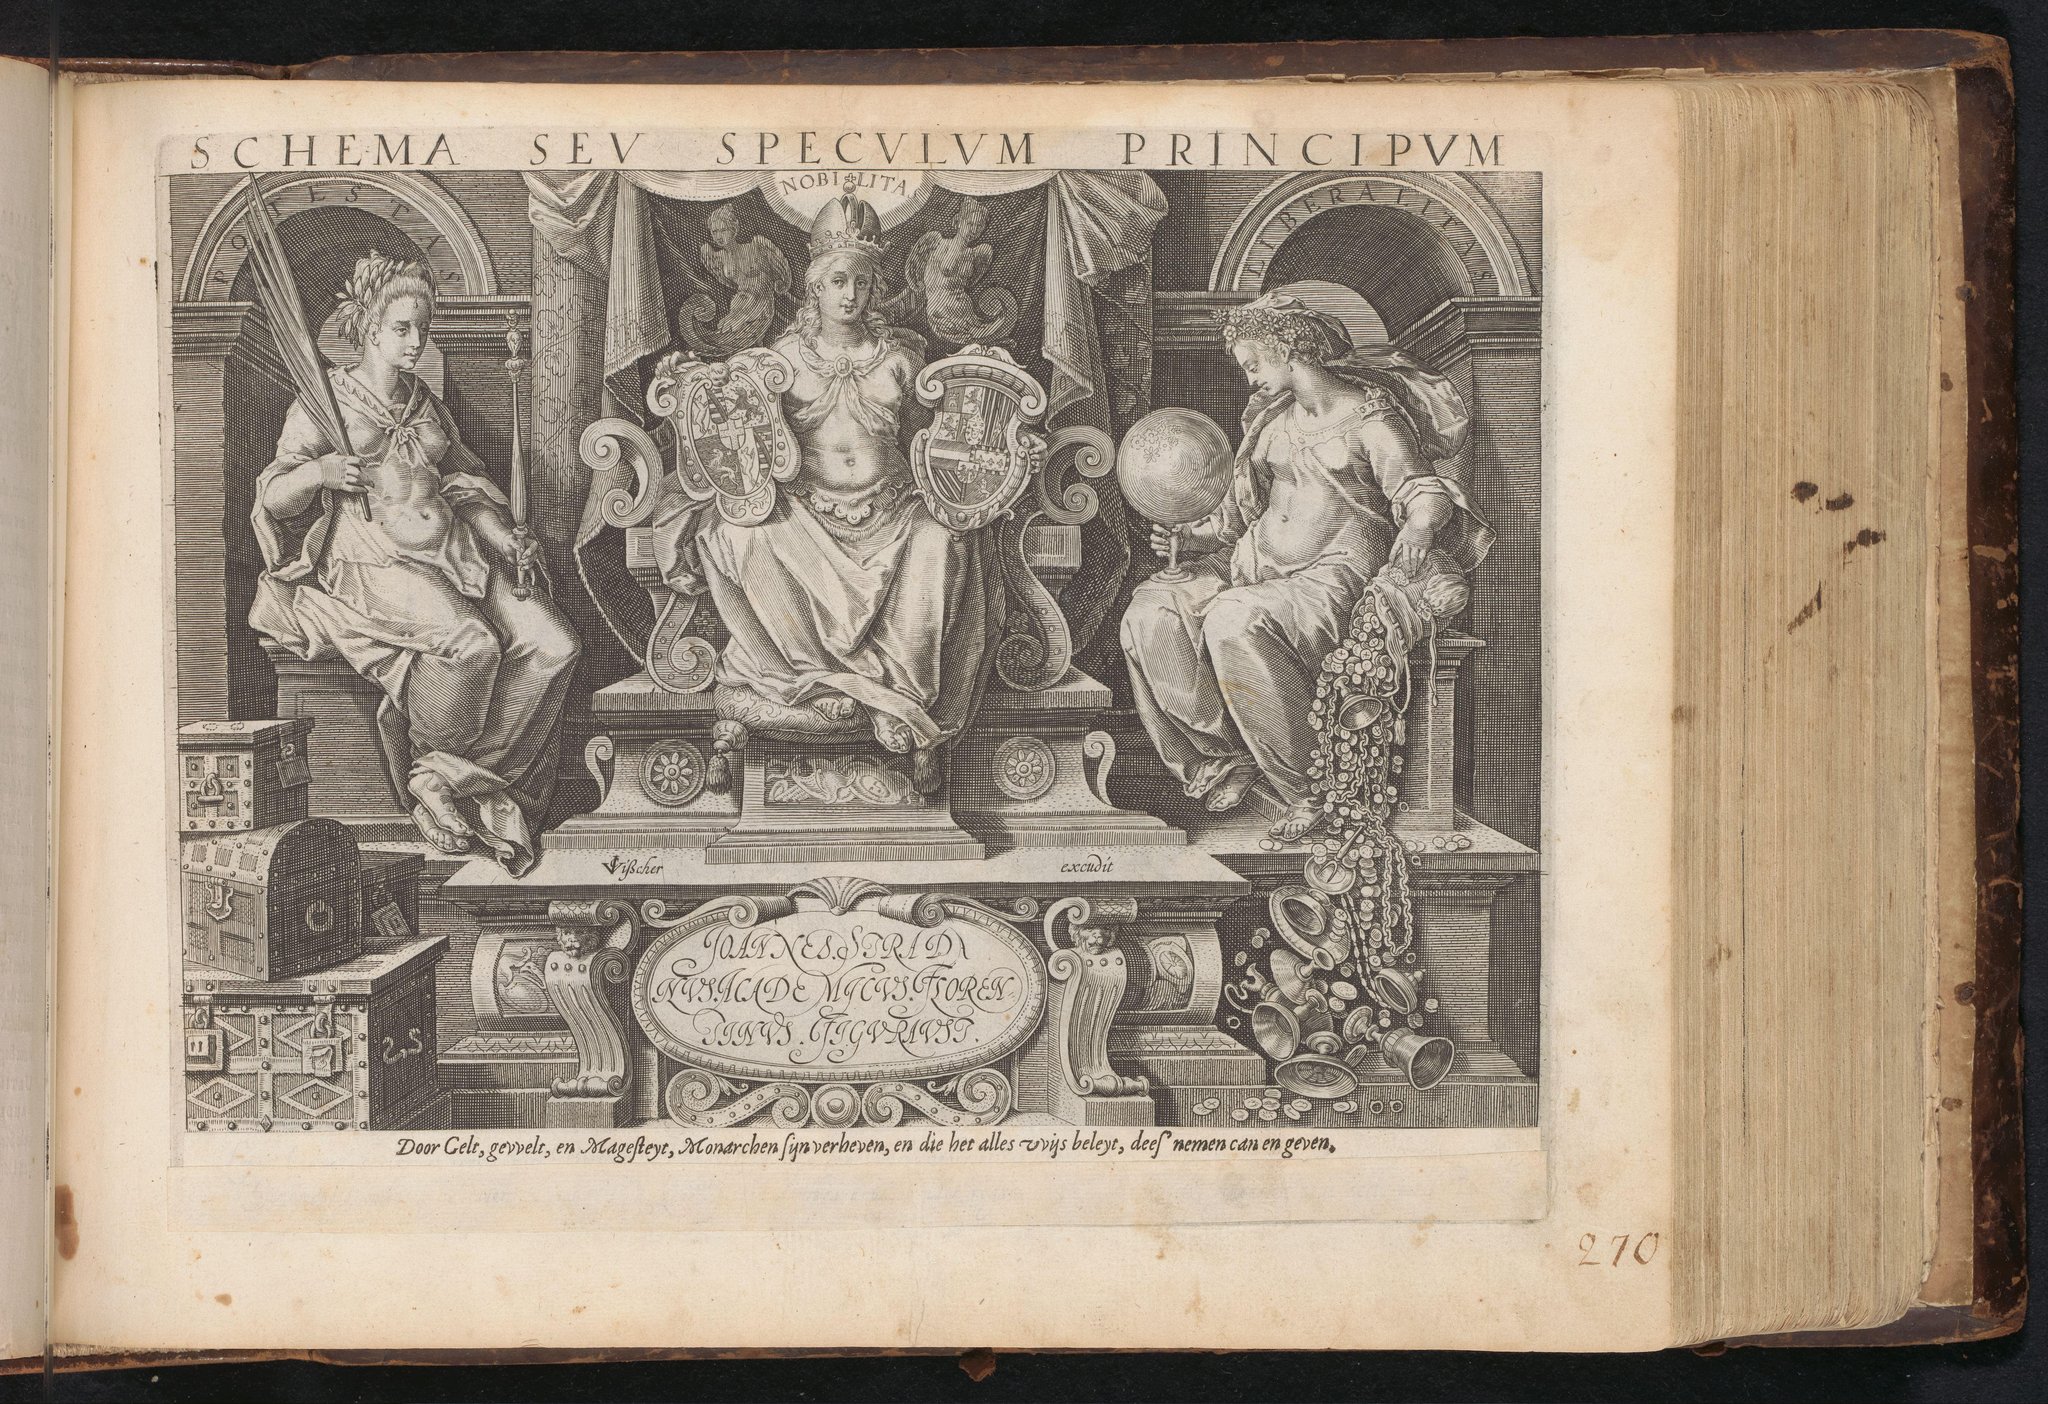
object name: album leaf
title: Door Gelt, gewelt, en Magesteyt, Monarchen syn verheven, en die het alles wijs beleyt, dess nemen can en geven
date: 1597-1646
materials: paper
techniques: engraving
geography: alkmaar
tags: power, 'potestas' ~ one of the seven gifts of the soul, nobility; 'nobiltà' (ripa), generosity, liberality; 'generosità', 'liberalità' (ripa), armorial bearing, heraldry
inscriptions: number: ‘270’, inscription: ‘Door Gelt, gewelt, en Magesteyt, Monarchen syn verheven, en die het alles wijs beleyt, dess nemen can en geven’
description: Titelprent met de vrouwelijke personificaties van drie belangrijke eigenschappen van een prins: Gezag (Potestas), Aanzien (Nobilitas) en Welwillendheid (Liberalitas). Potestas draagt een palmtak en een scepter. Nobilitas zit op een troon met de wapenschilden van de hertog van Savoye en de Habsburgers. Liberalitas houdt een wereldbol vast en ledigt een beurs met geld. Deze prent maakt deel uit van een album.